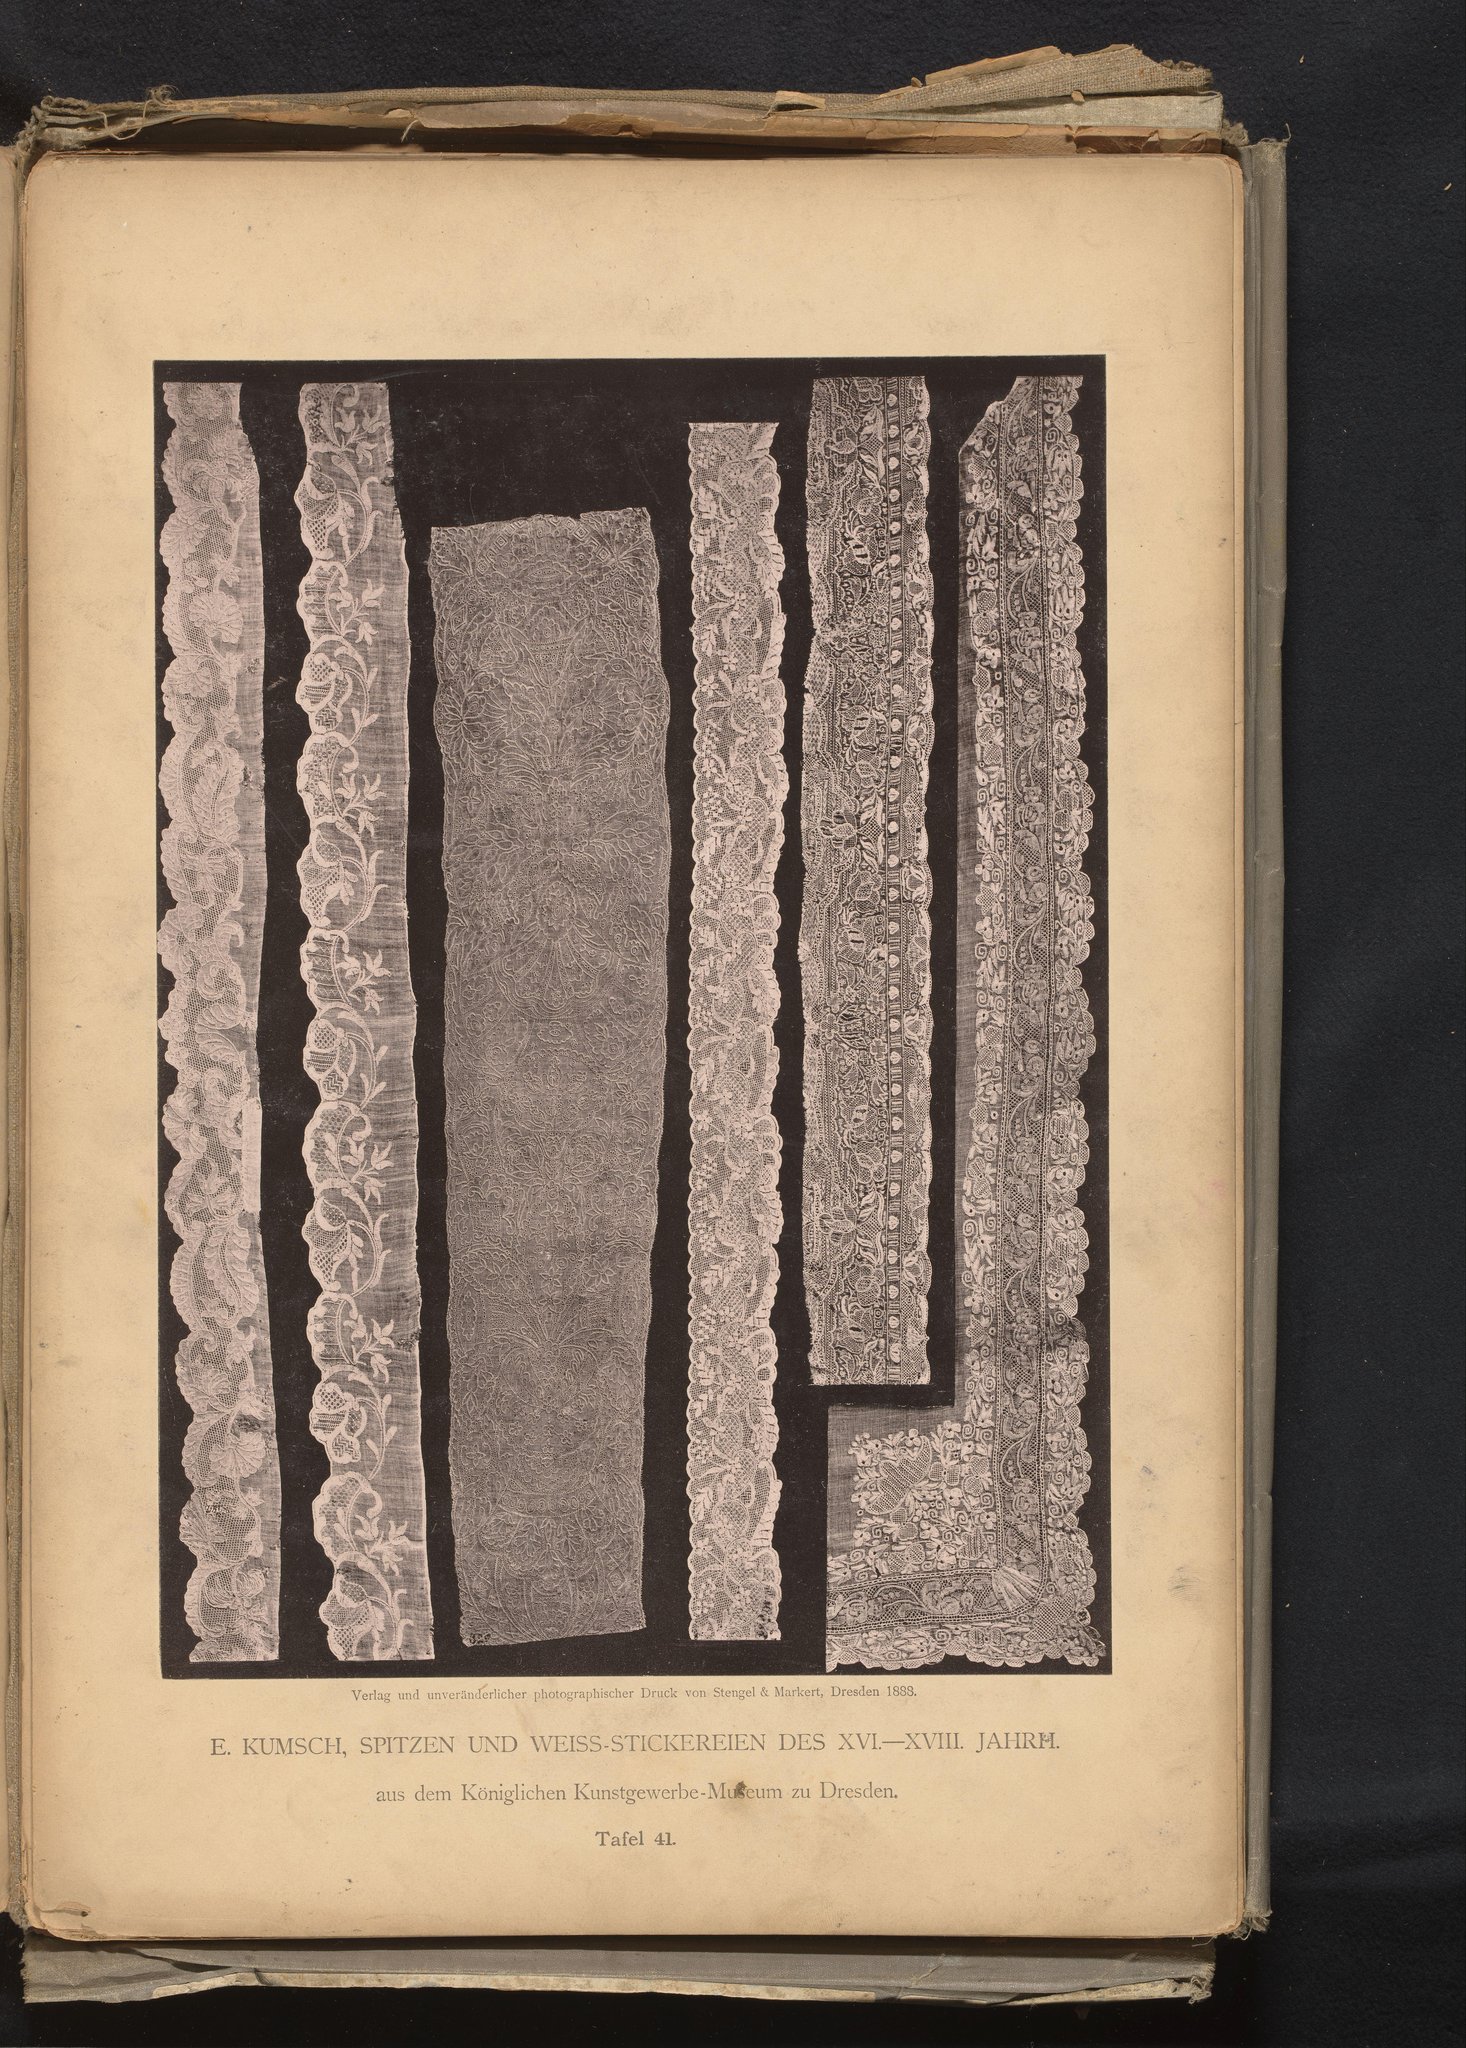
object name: photomechanical print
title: Vijf stroken Duits kant uit circa 1770 en een brede strook 18de-eeuws Duits kant, uit de collectie van het Kunstgewerbemuseum in Dresden, Duitsland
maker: Anonymous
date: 1888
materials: paper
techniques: photograph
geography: dresden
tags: lace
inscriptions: number: ‘Tafel 41.’, inscription: ‘E. KUMSCH, SPITZEN UND WEISS-STICKEREIEN DES XVI.-XVIII. JAHRH./ aus dem Königlichen Kunstgewerbe-Museum zu Dresden’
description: Deze prent maakt deel uit van een omslag met 49 prenten en een lijst van afbeeldingen.